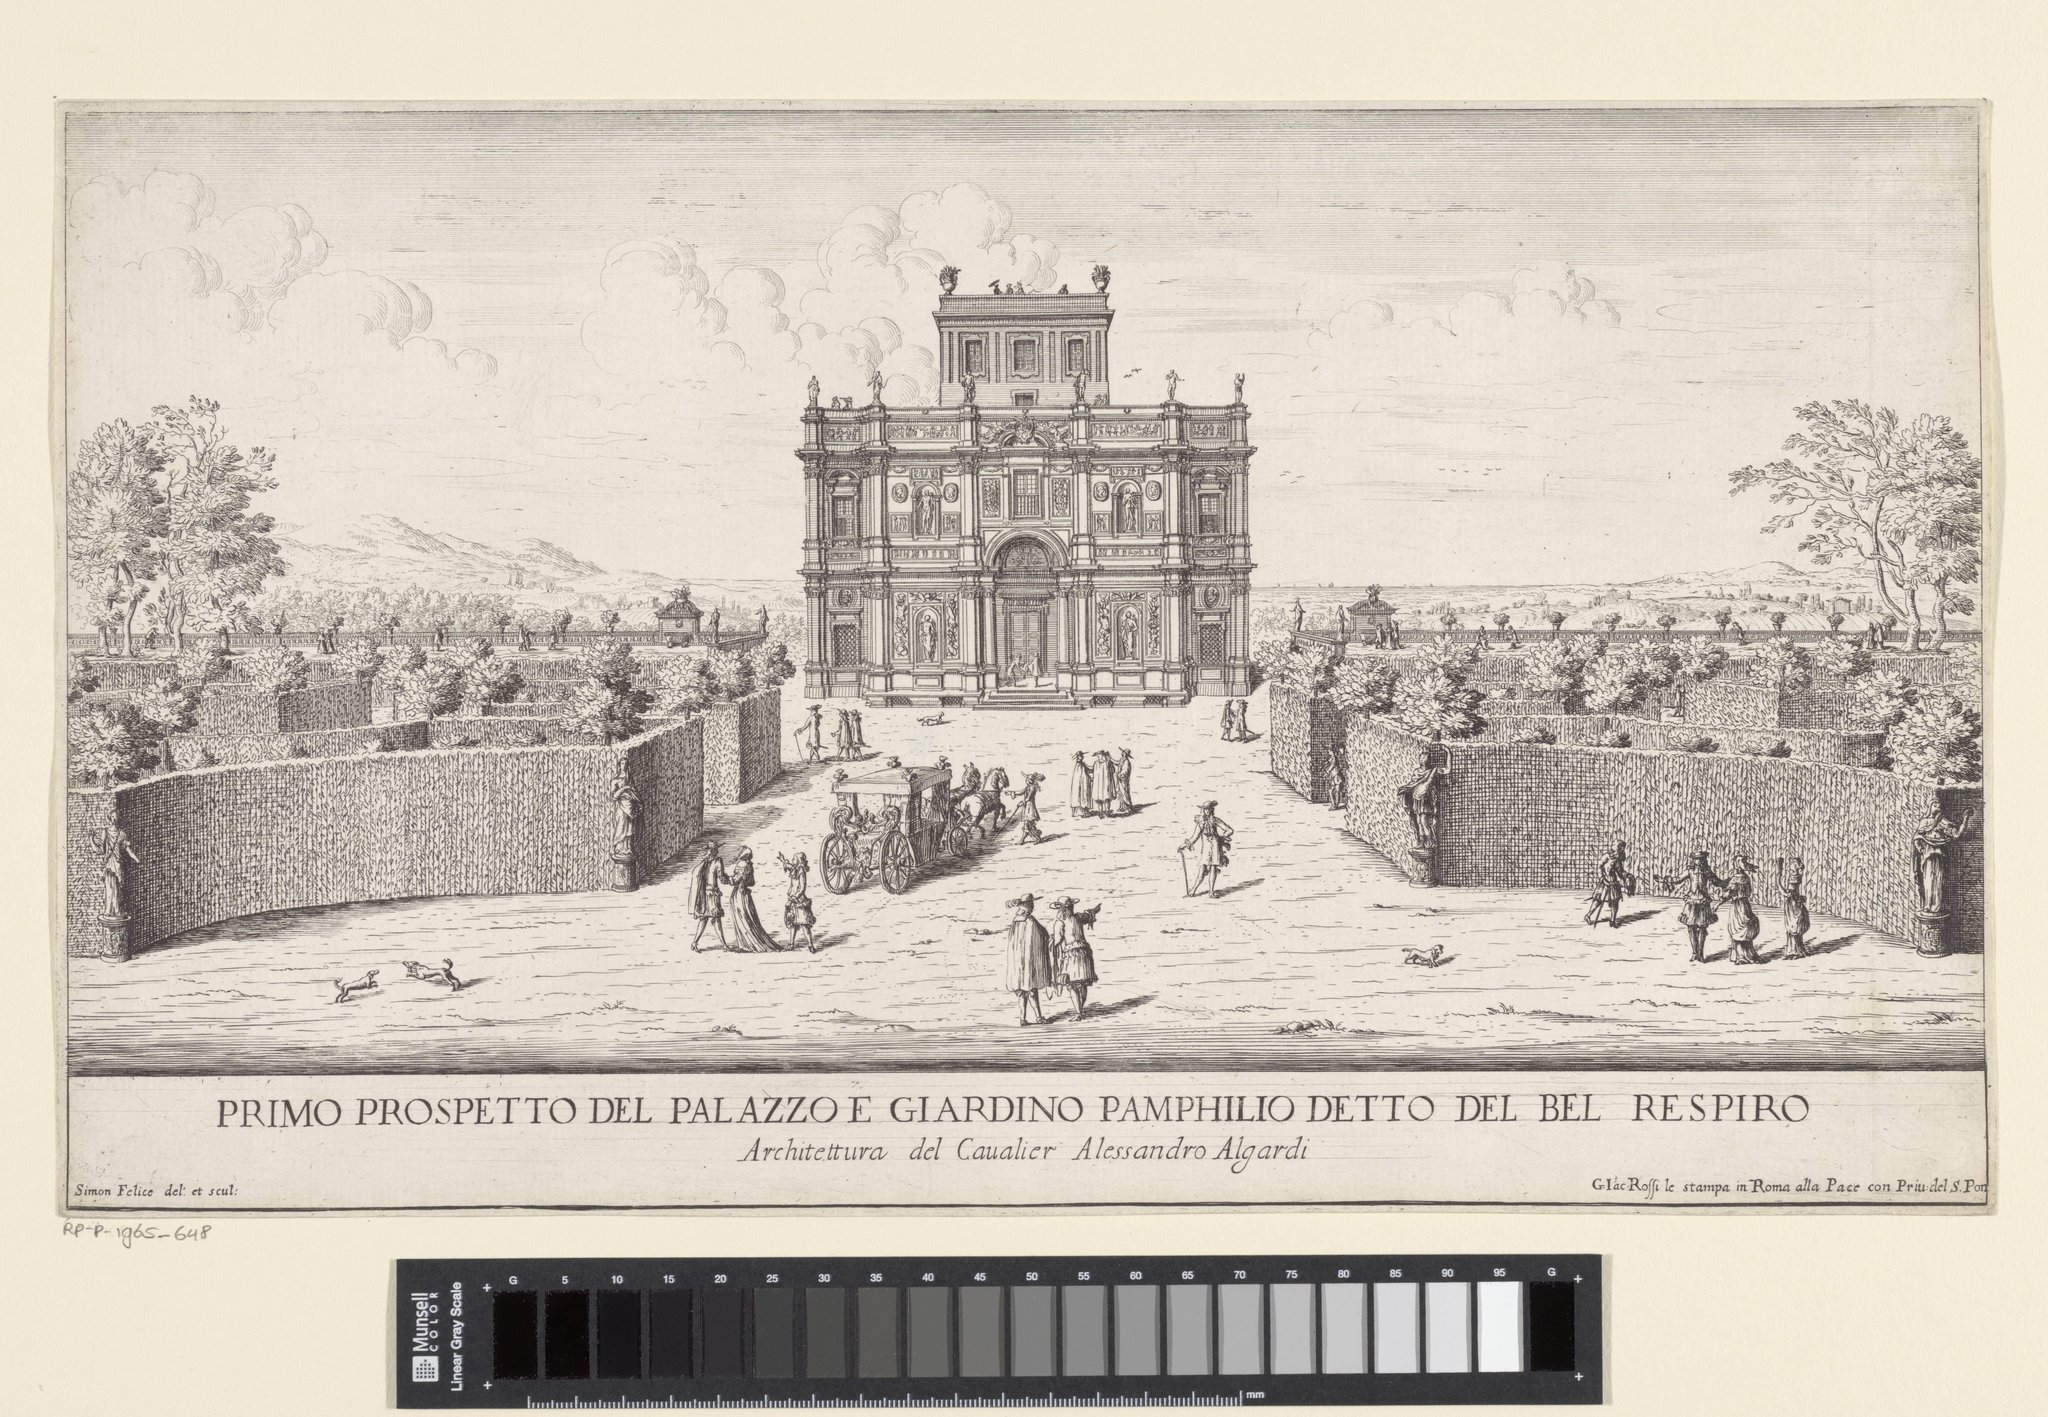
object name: print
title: Primo prospetto del Palazzo e Giardino Pamphilio detto del bel respiro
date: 1600-1699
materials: paper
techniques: etching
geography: rome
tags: city-view in general; 'veduta', garden, villa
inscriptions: collector's mark: Lugt 2228, collector's mark: Lugt 2760